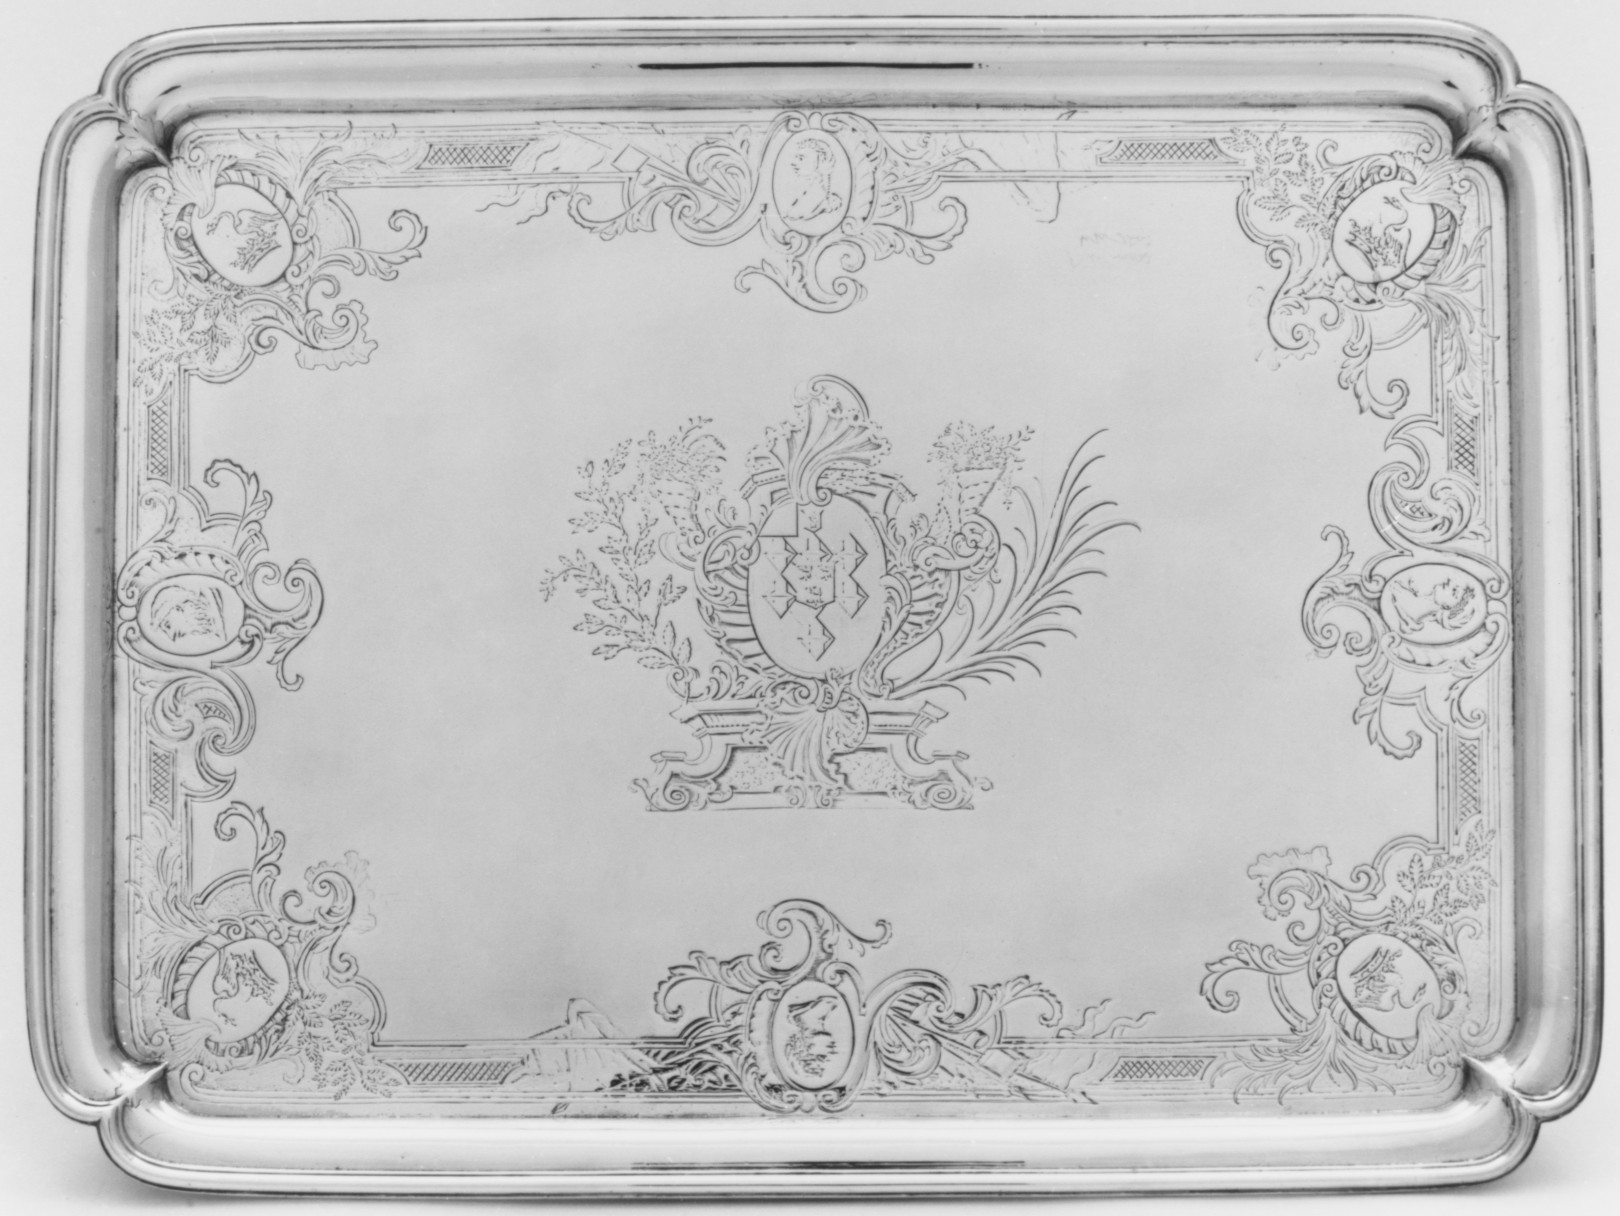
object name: salver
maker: paul de lamerie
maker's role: maker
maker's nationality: british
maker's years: 1688-1751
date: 1733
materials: silver